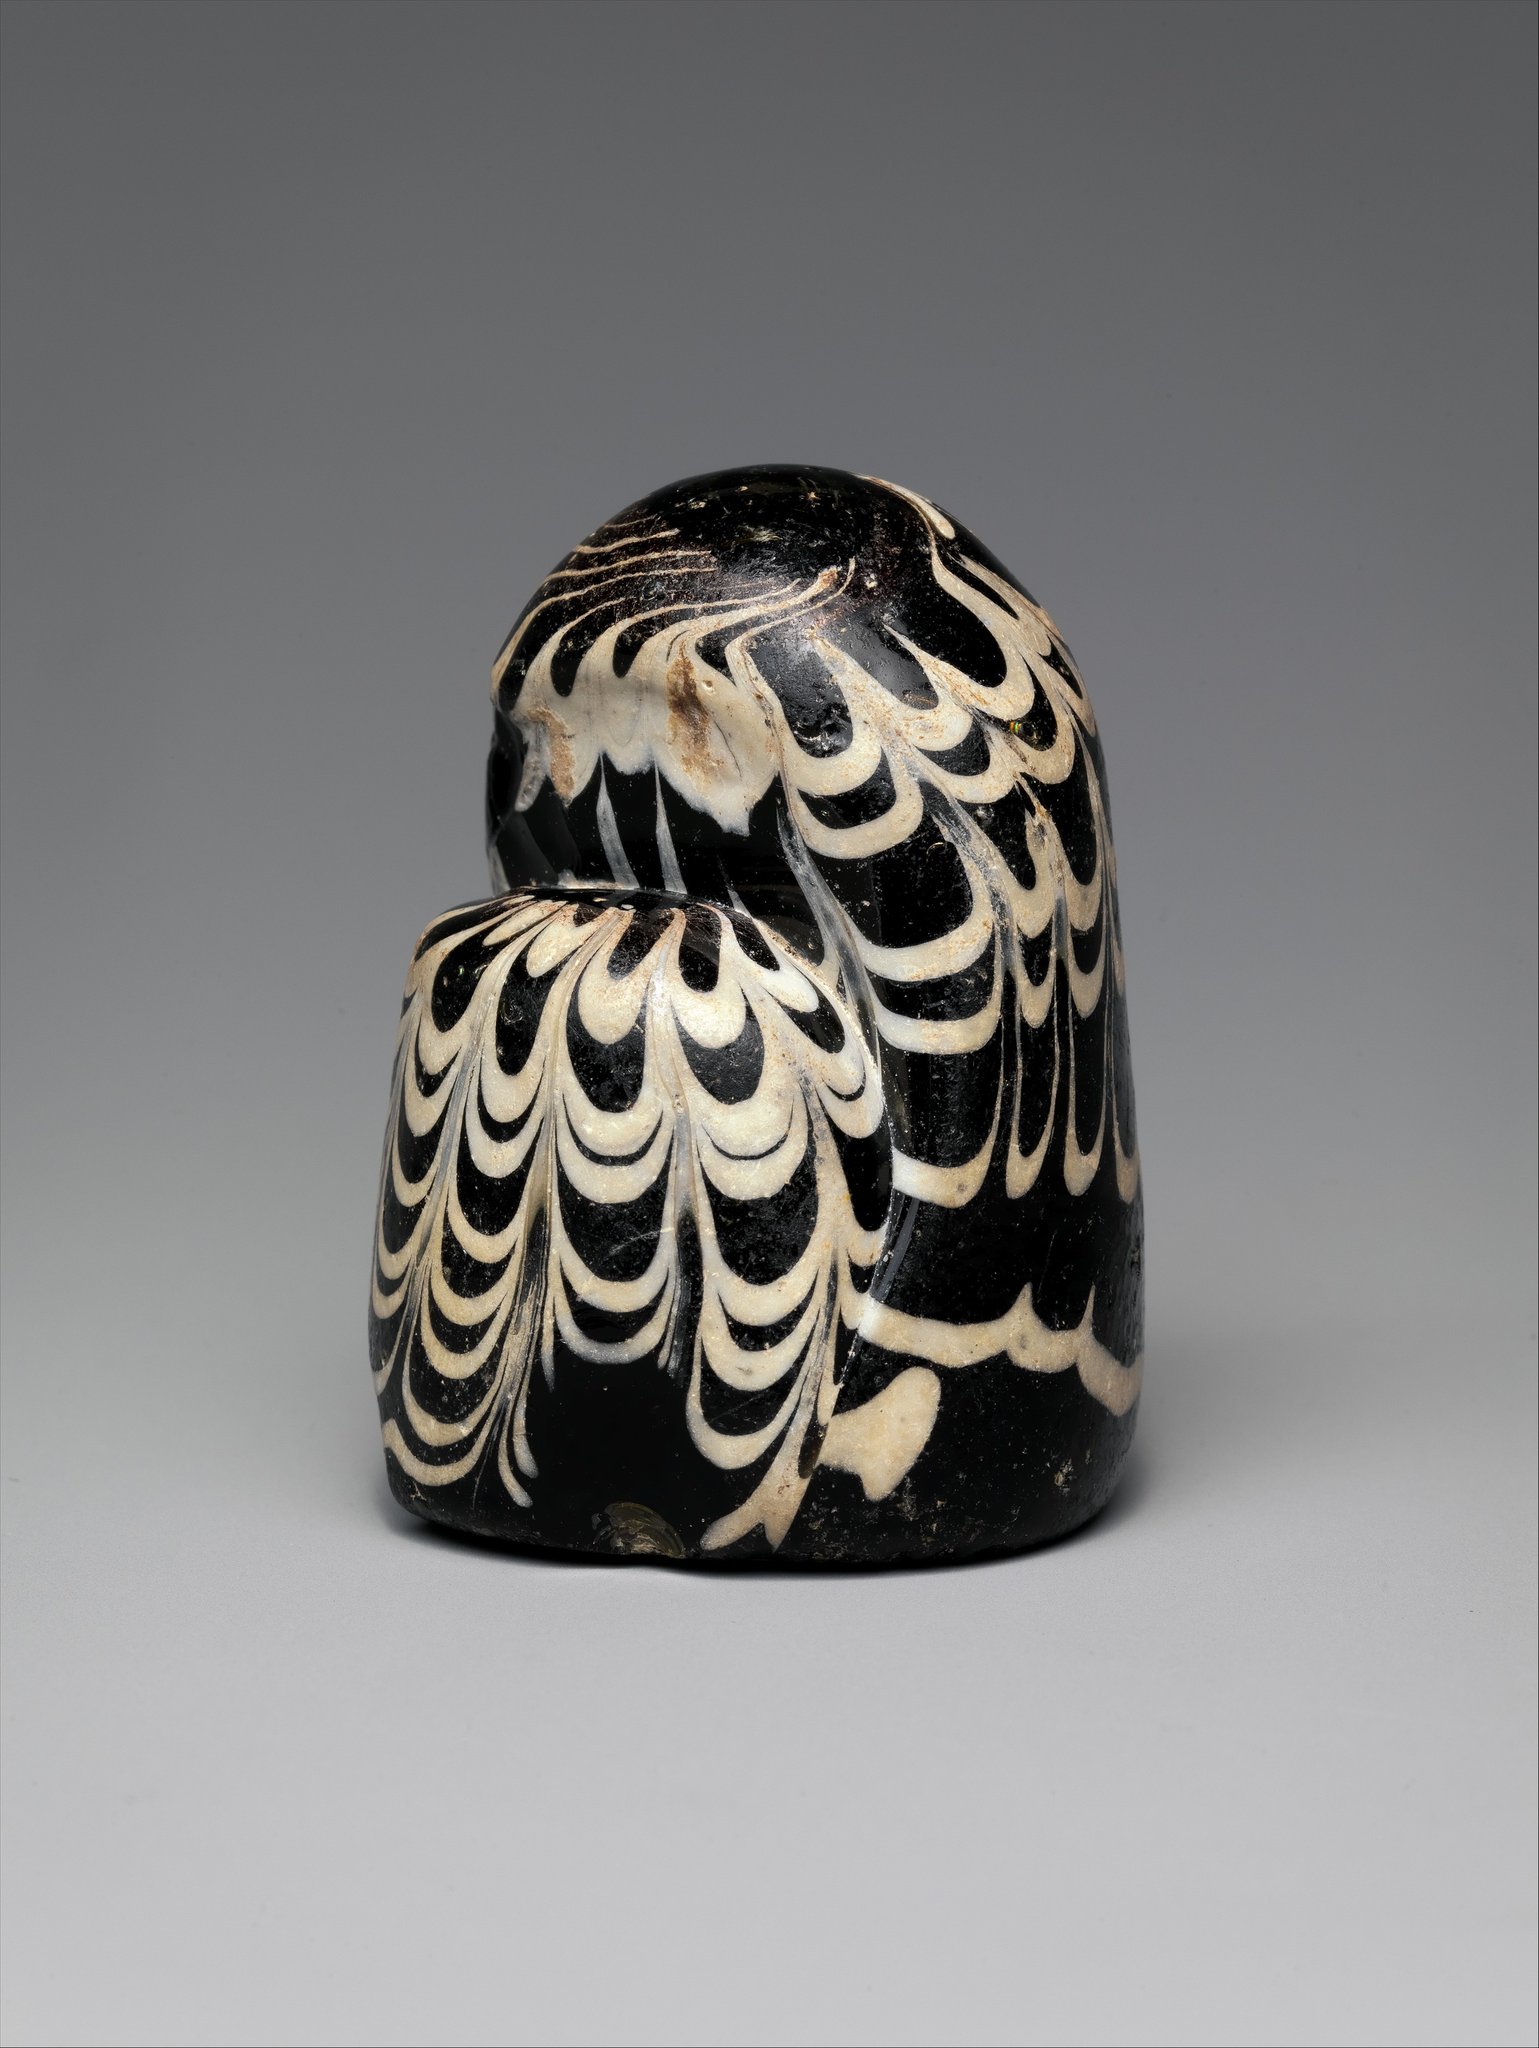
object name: chess piece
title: Chess Piece, King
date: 1201-1400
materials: glass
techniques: tooling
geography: egypt or syria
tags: chess